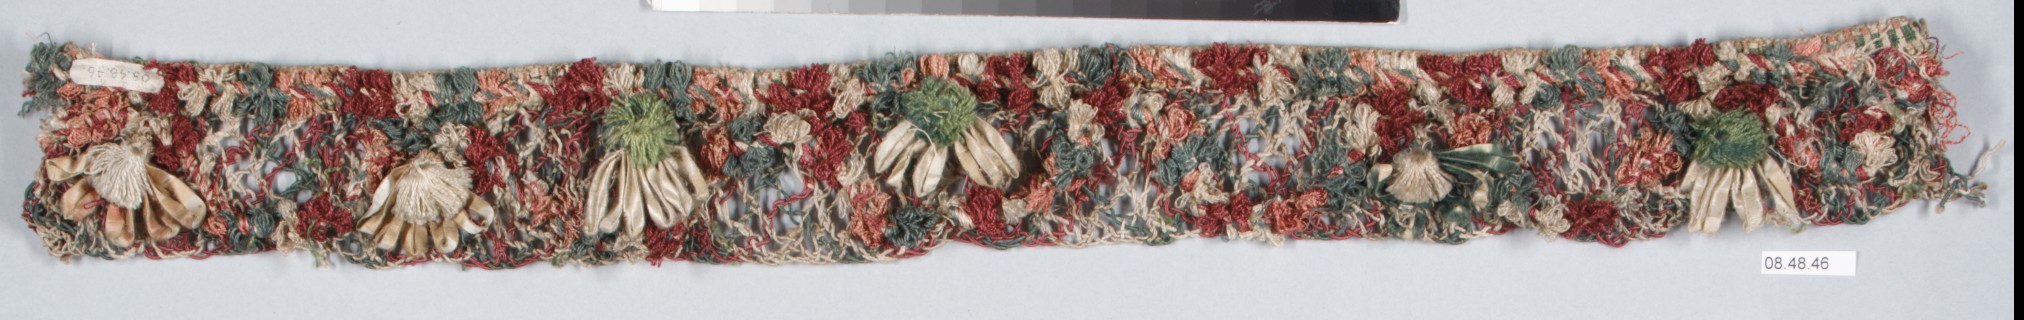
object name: passementerie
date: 1701-1800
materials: silk